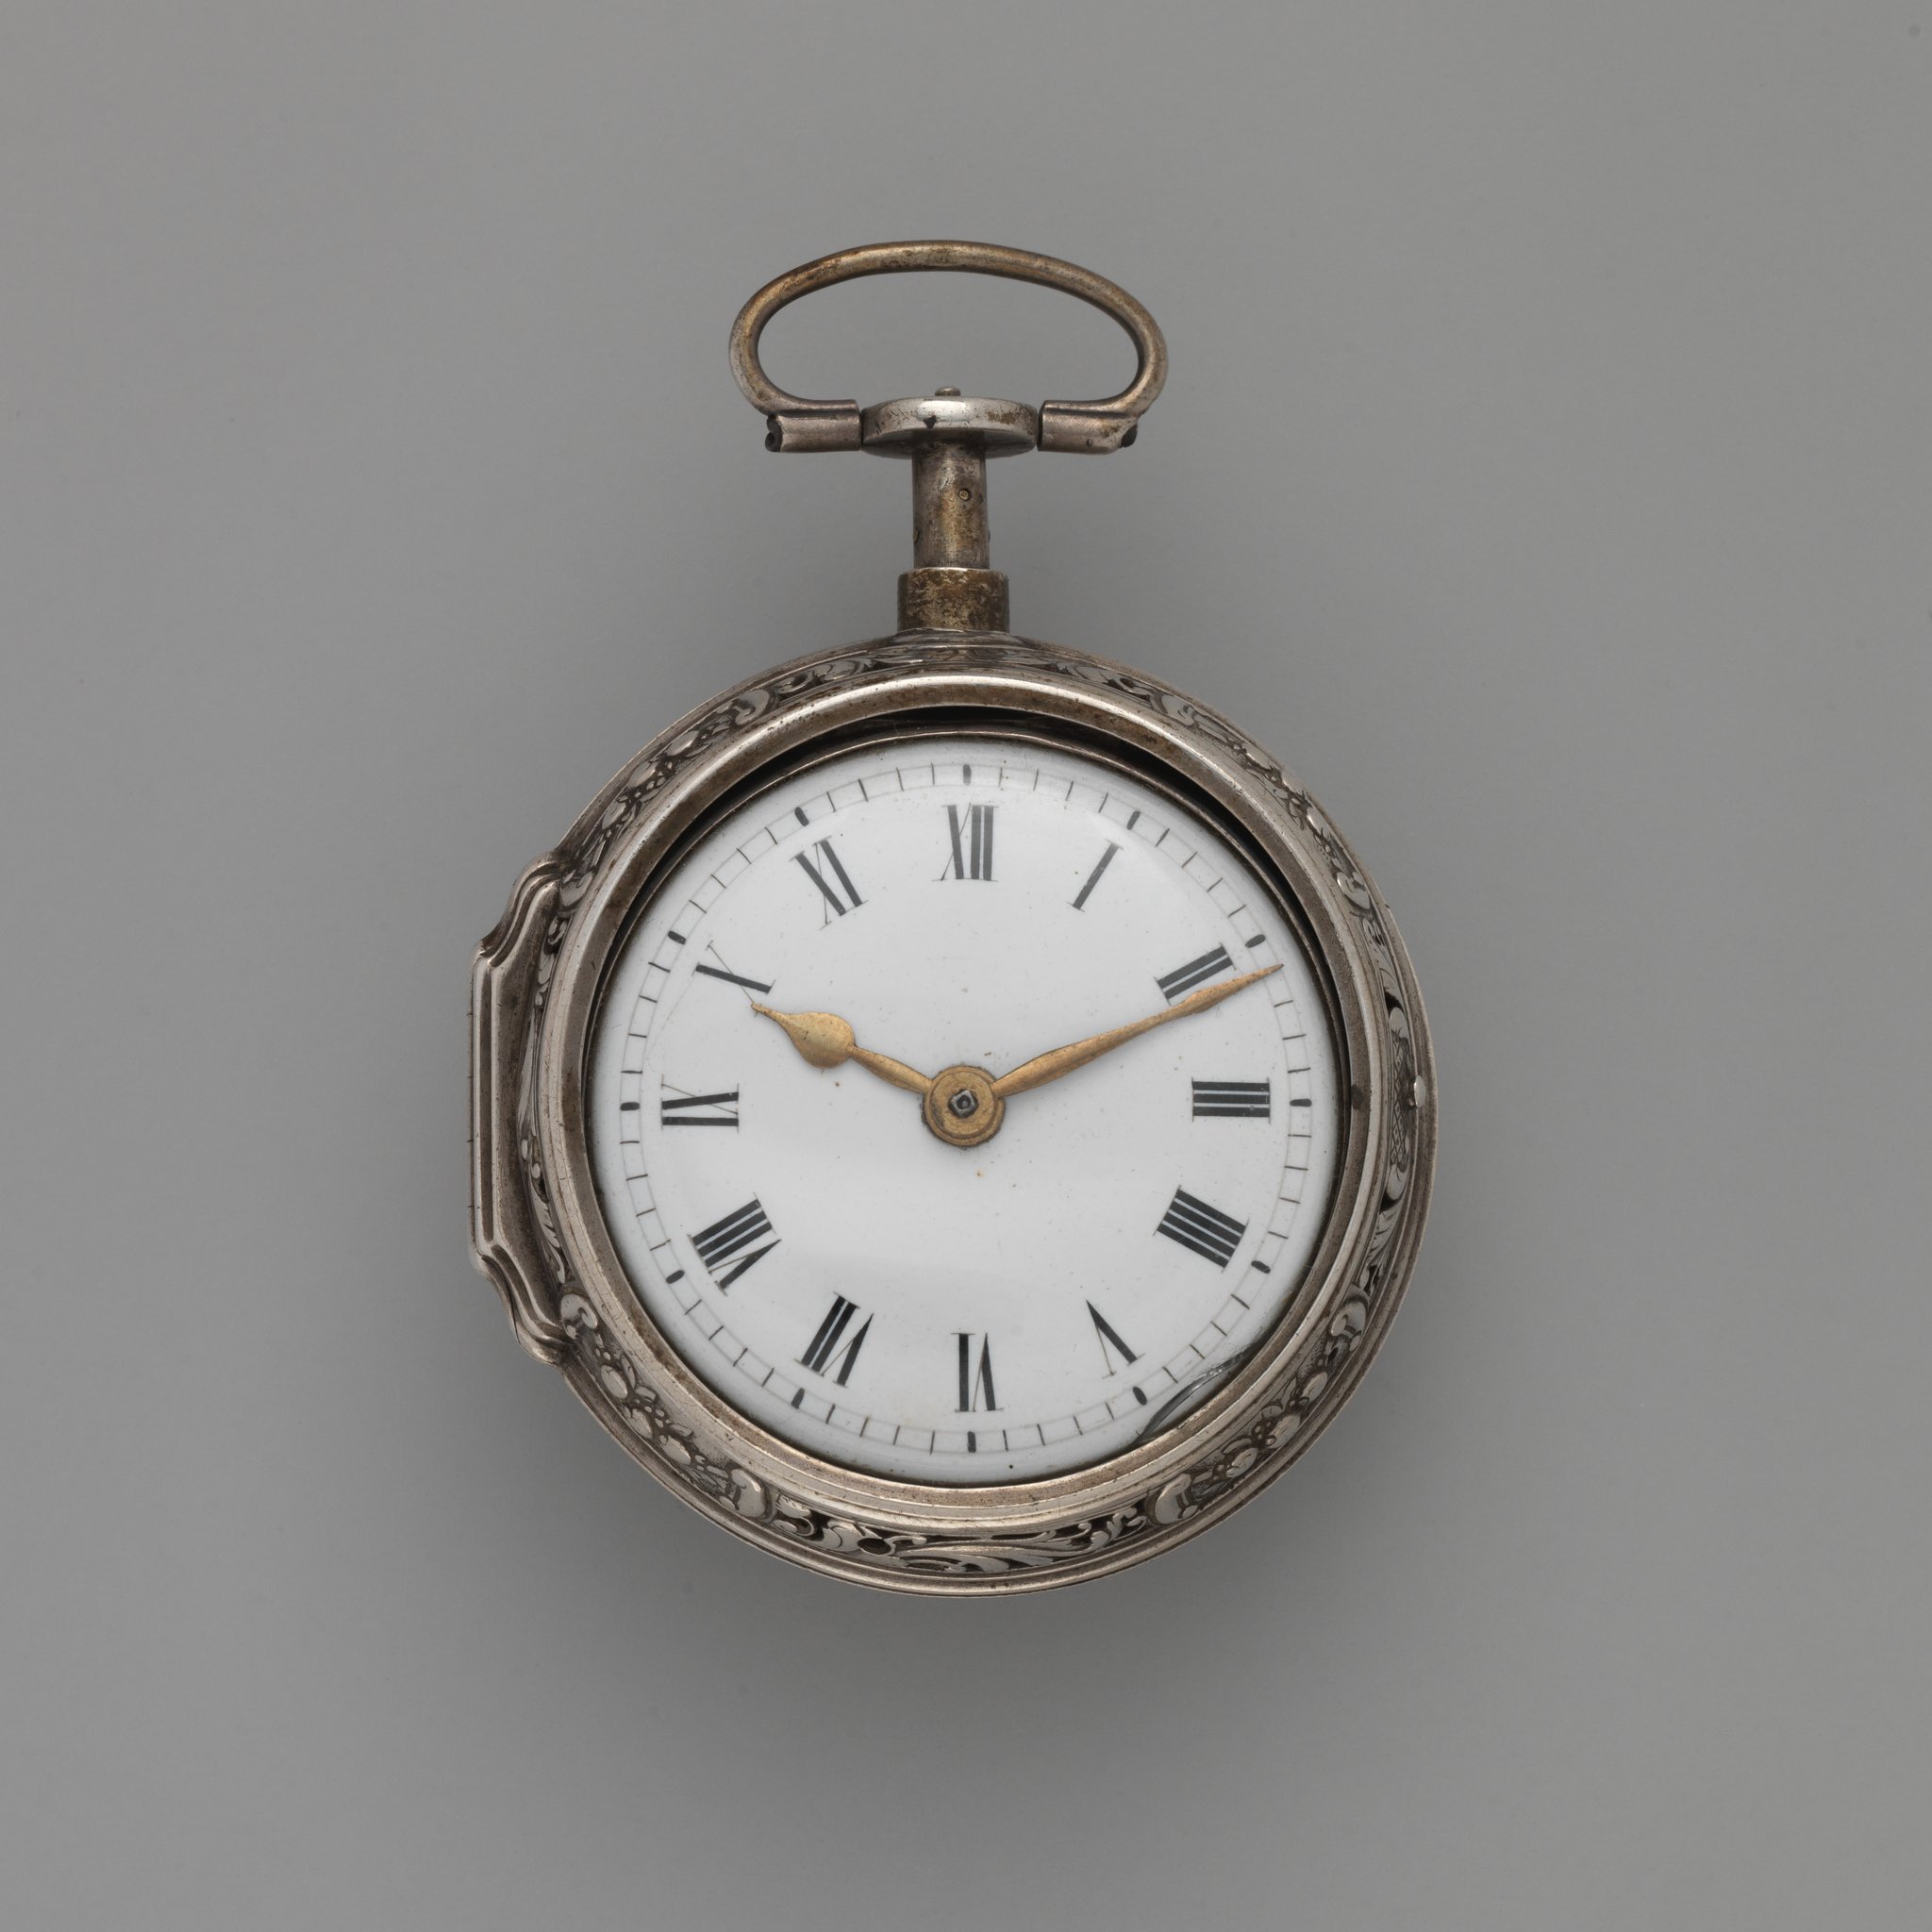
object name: clock watch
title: Clock-watch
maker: gabriel tallans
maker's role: maker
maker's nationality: swiss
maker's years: 1675-1775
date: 1720-1740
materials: enamel, silver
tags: men,owls,trees